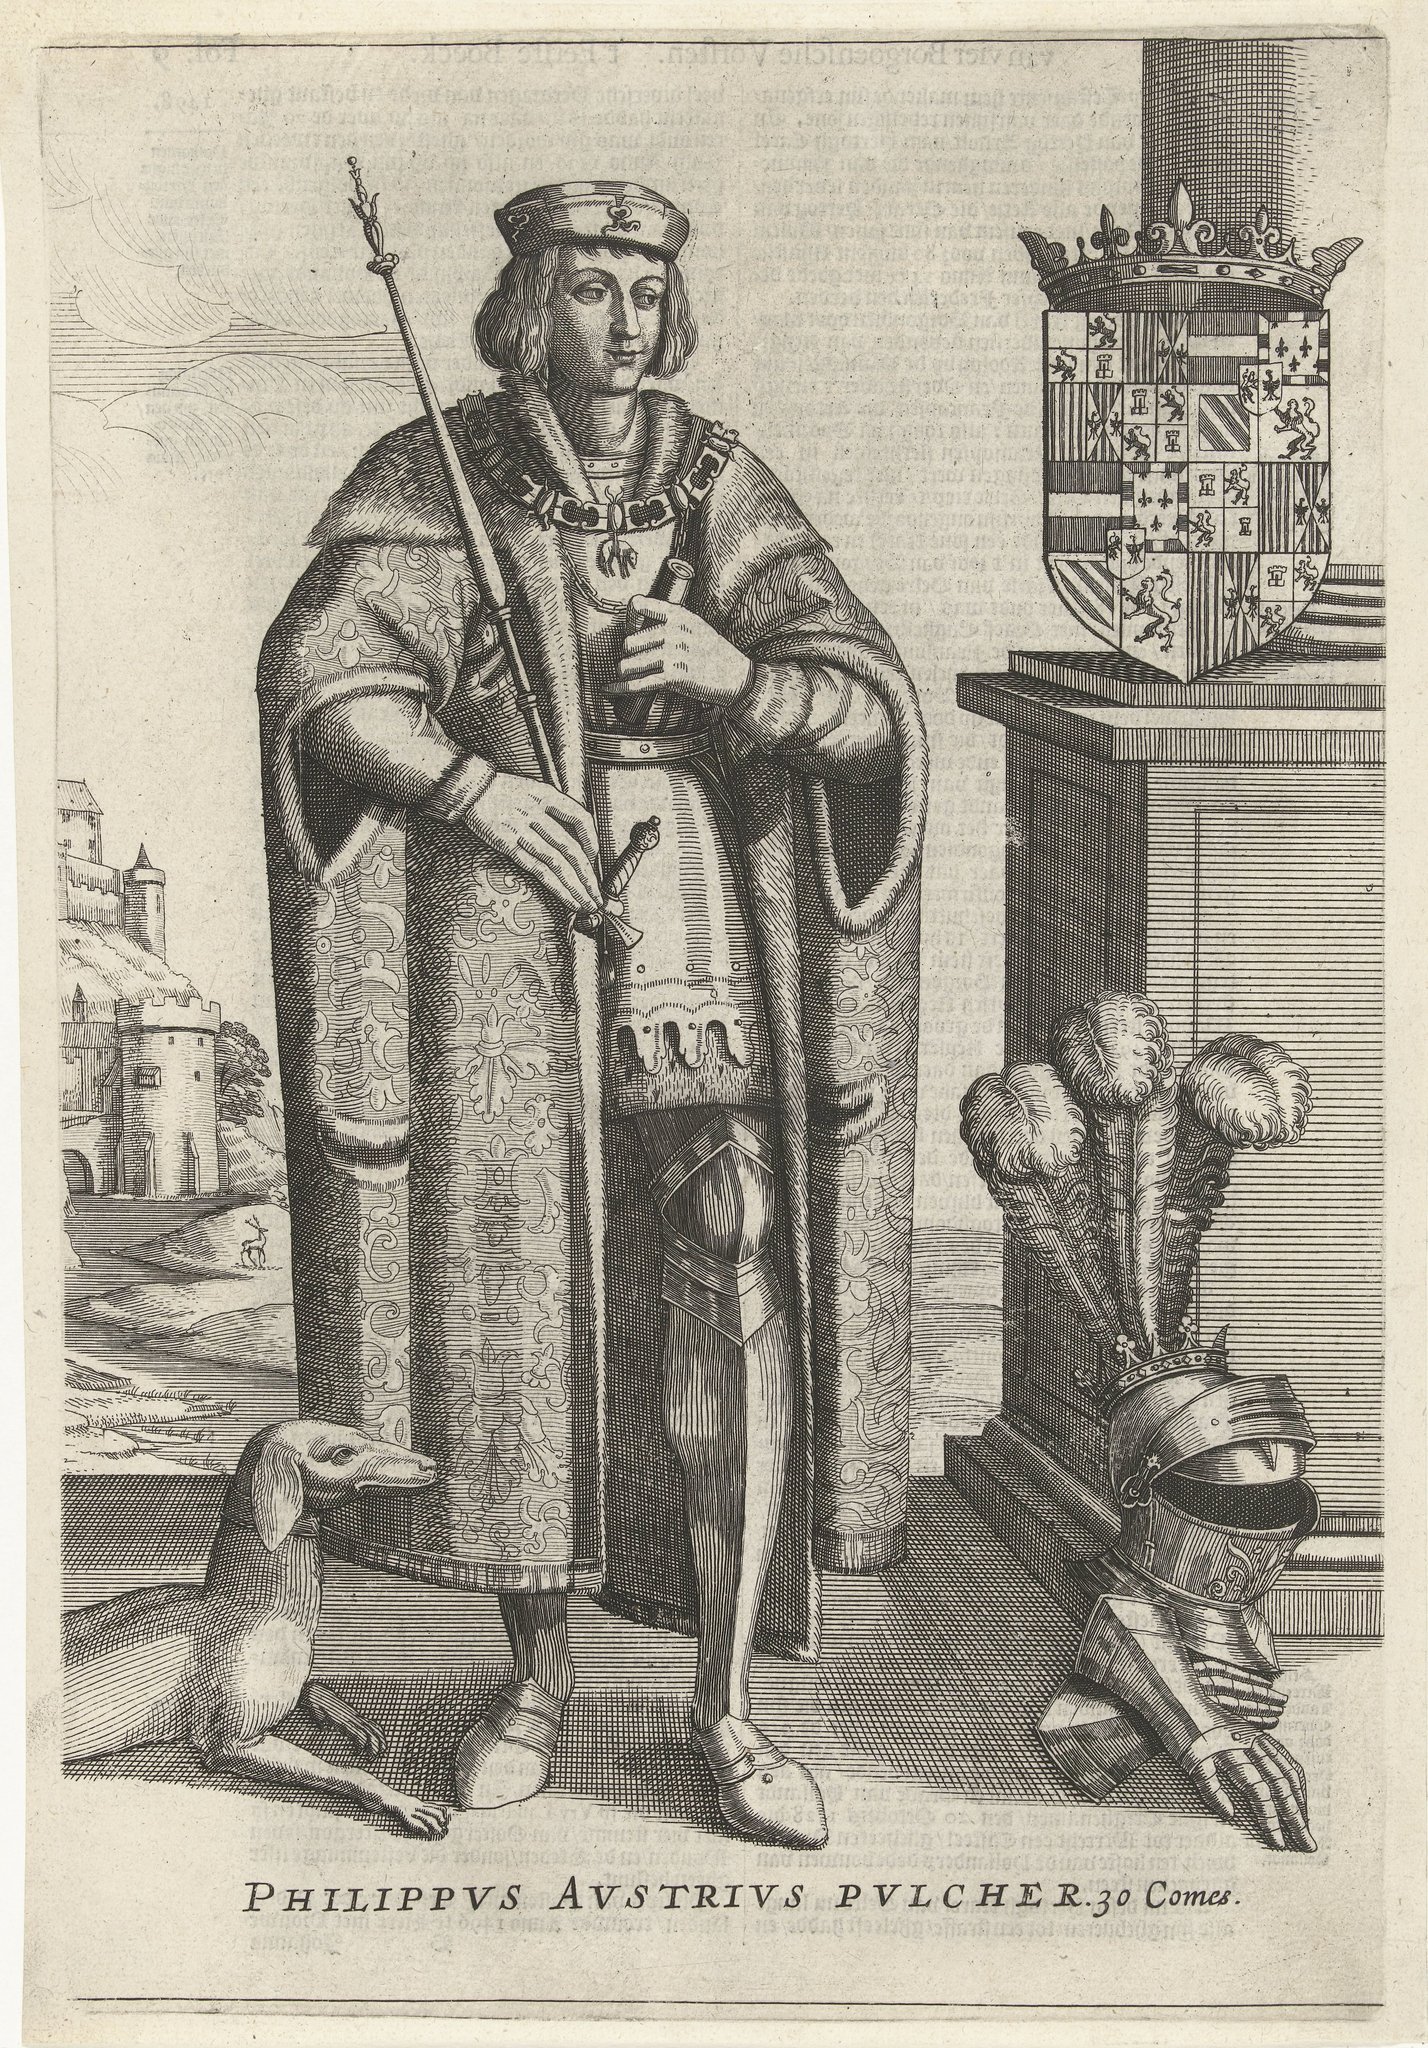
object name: book illustration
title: Philippvs Avstrivs Pvlcher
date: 1628-1688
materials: paper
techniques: etching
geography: amsterdam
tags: filips de schone (hertog van bourgondië)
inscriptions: collector's mark: Lugt 2228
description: Portret van Filips de Schone, hertog van Bourgondië. Staande, ten voeten uit. In zijn rechterhand een scepter. Een hond ligt aan zijn voeten. Naast hem een helm en zijn wapenschild.